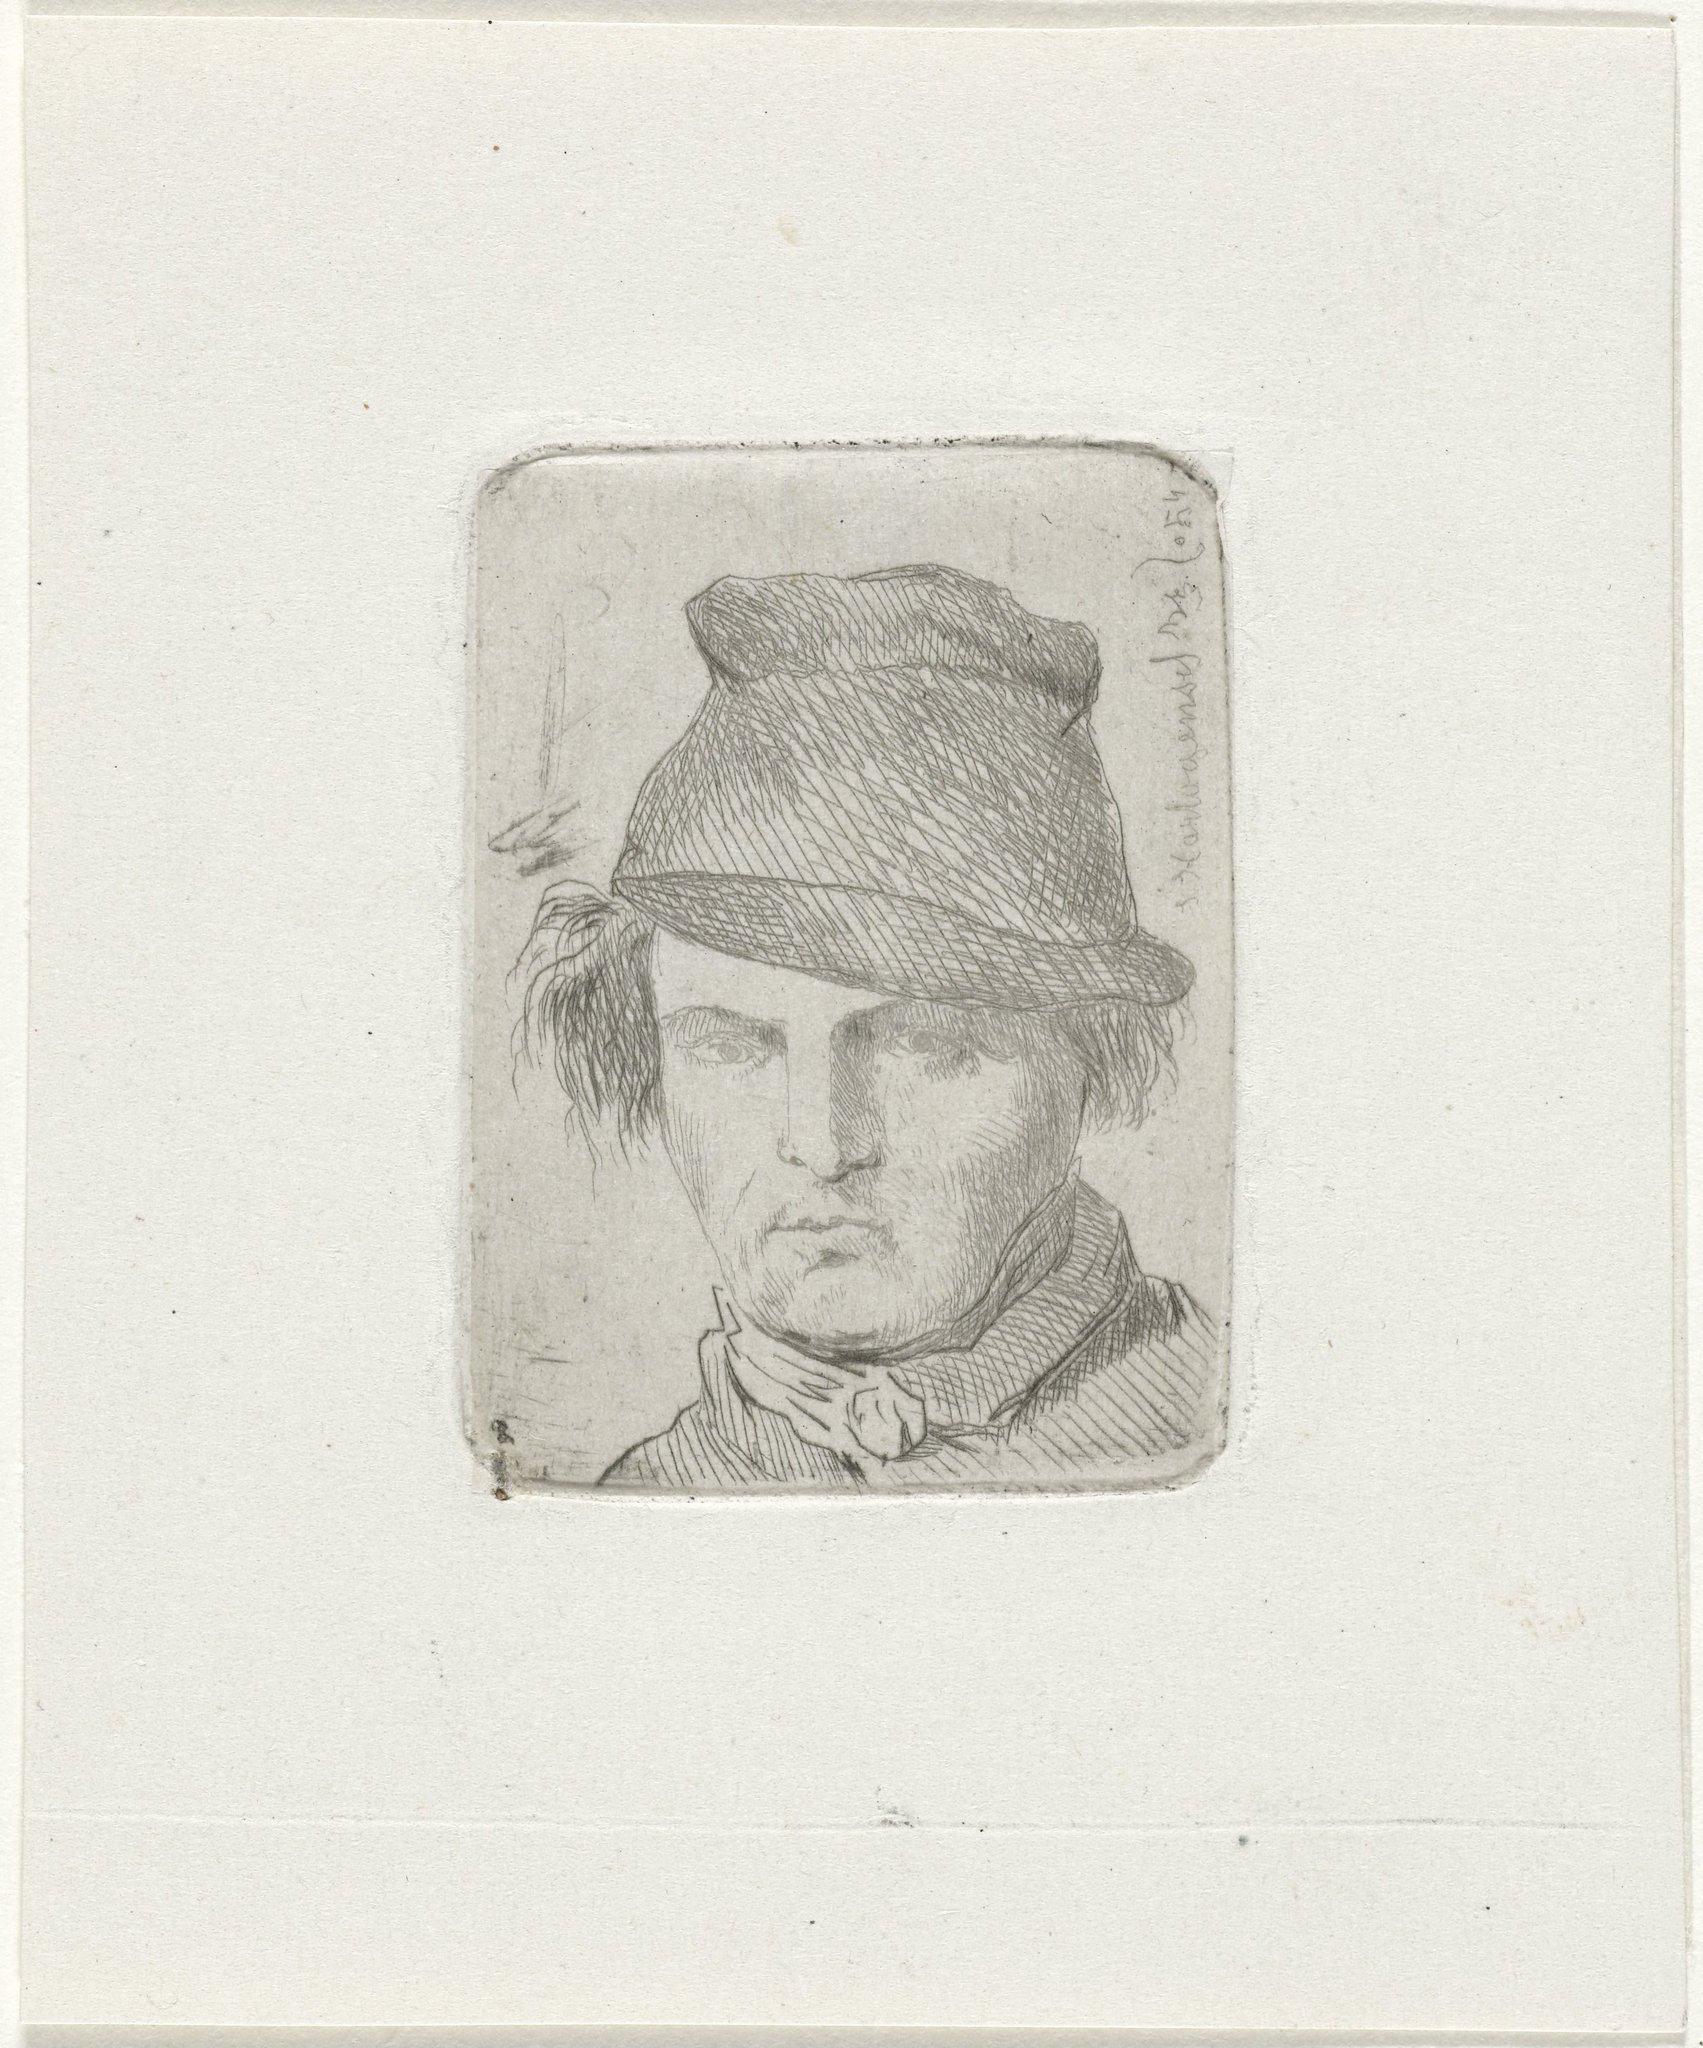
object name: print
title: Hoofd van een man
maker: joseph hartogensis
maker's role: painter, print maker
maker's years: 1822-1865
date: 1854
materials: paper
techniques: etching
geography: the hague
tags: adult man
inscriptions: collector's mark: Lugt 2228